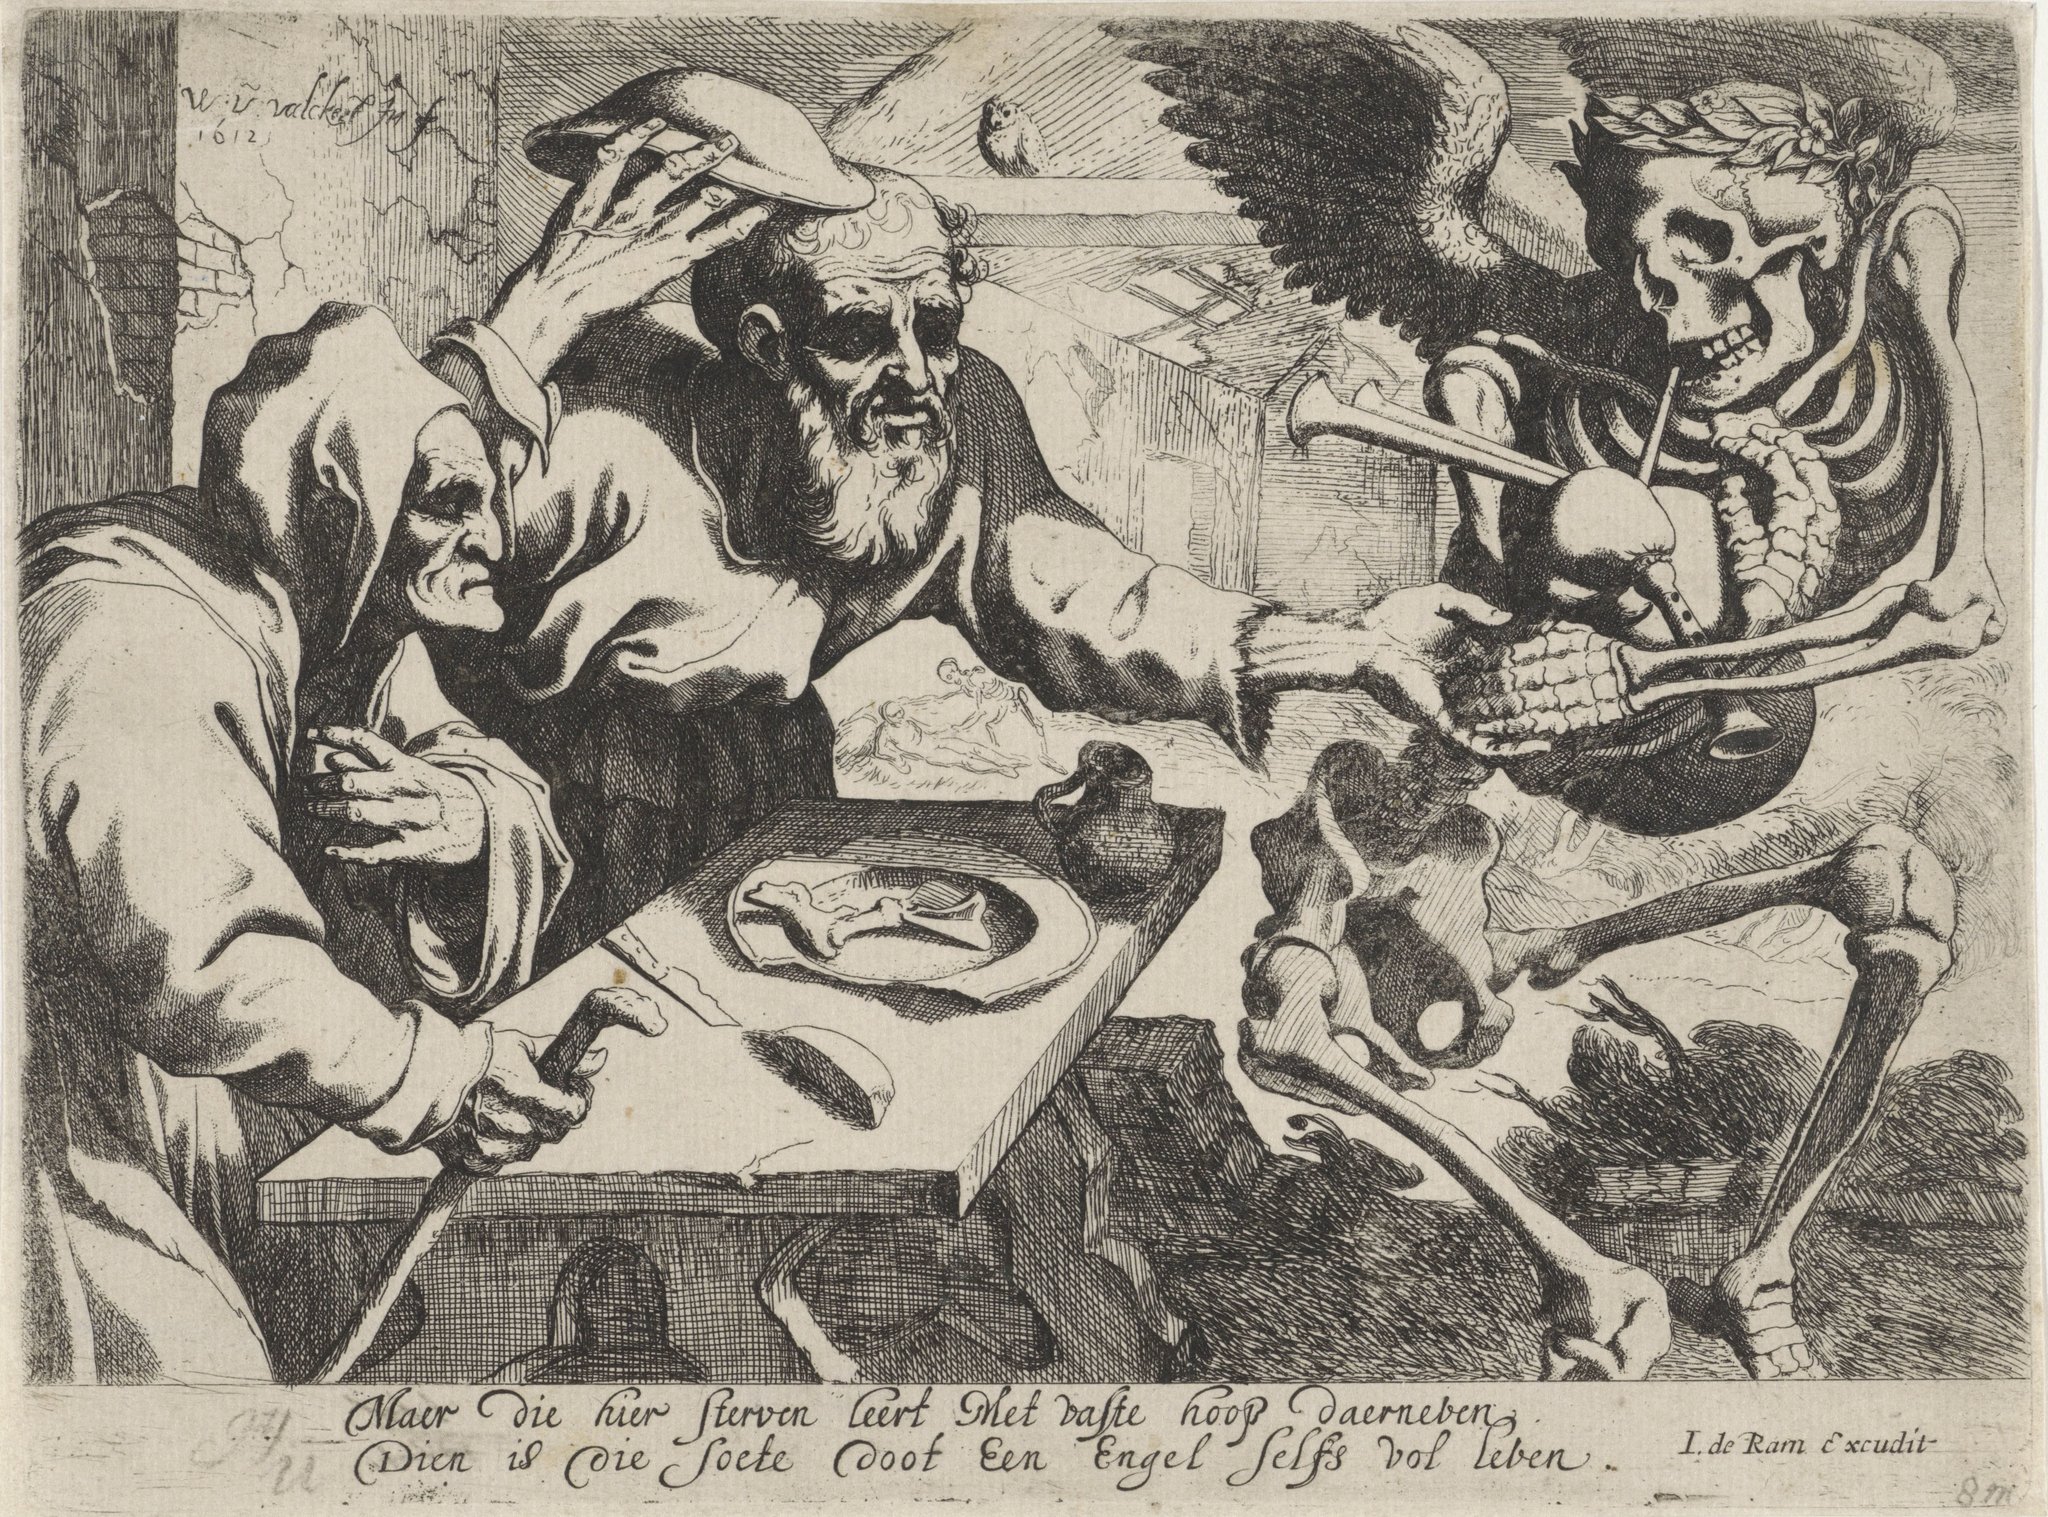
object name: print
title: Oud paar met doedelzakspelende Dood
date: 1610-1612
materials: paper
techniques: etching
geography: amsterdam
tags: death as skeleton (+ death with musical instrument), death in old age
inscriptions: collector's mark: Lugt 2228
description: Een oud paar bij een tafel waarop een bord met een bot, begroet de Dood, spelend op een doedelzak. De man neemt zijn hoed af en geeft zijn hand aan de Dood. De vrouw maakt een eerbiedig gebaar met haar hand tegen haar borst.